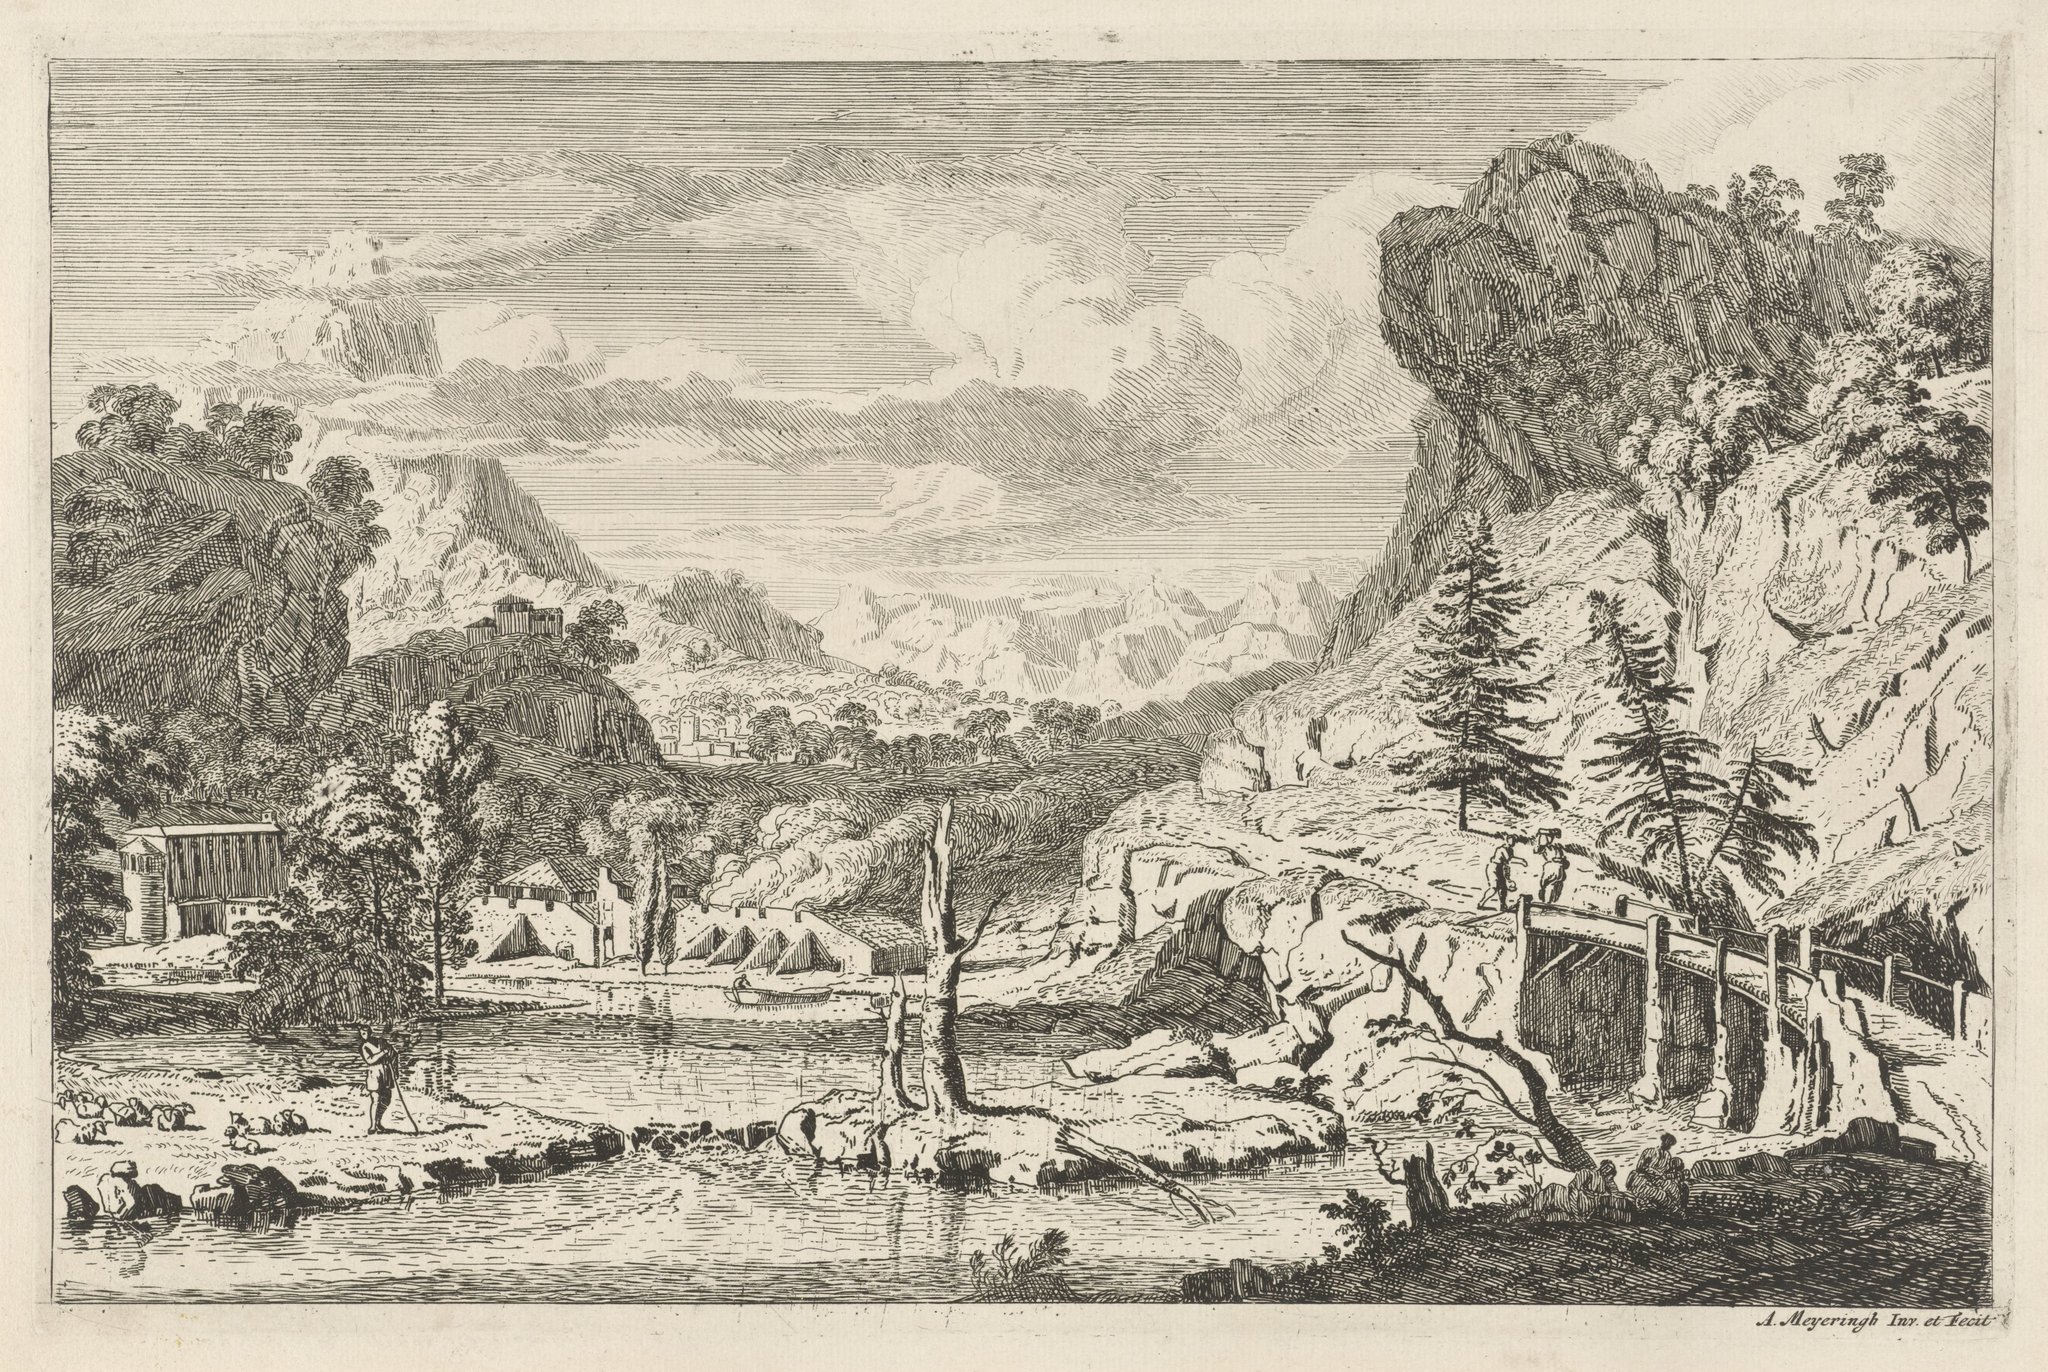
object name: print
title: Rivierlandschap met een brug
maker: albert meyering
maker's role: draughtsman, print maker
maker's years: 1645-1714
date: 1665-1714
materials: paper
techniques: etching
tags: river, landscape with bridge, viaduct or aqueduct, mountains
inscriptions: collector's mark: Lugt 2228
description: Berglandschap met een rivier. Rechts een brug en links een herder met zijn kudde.